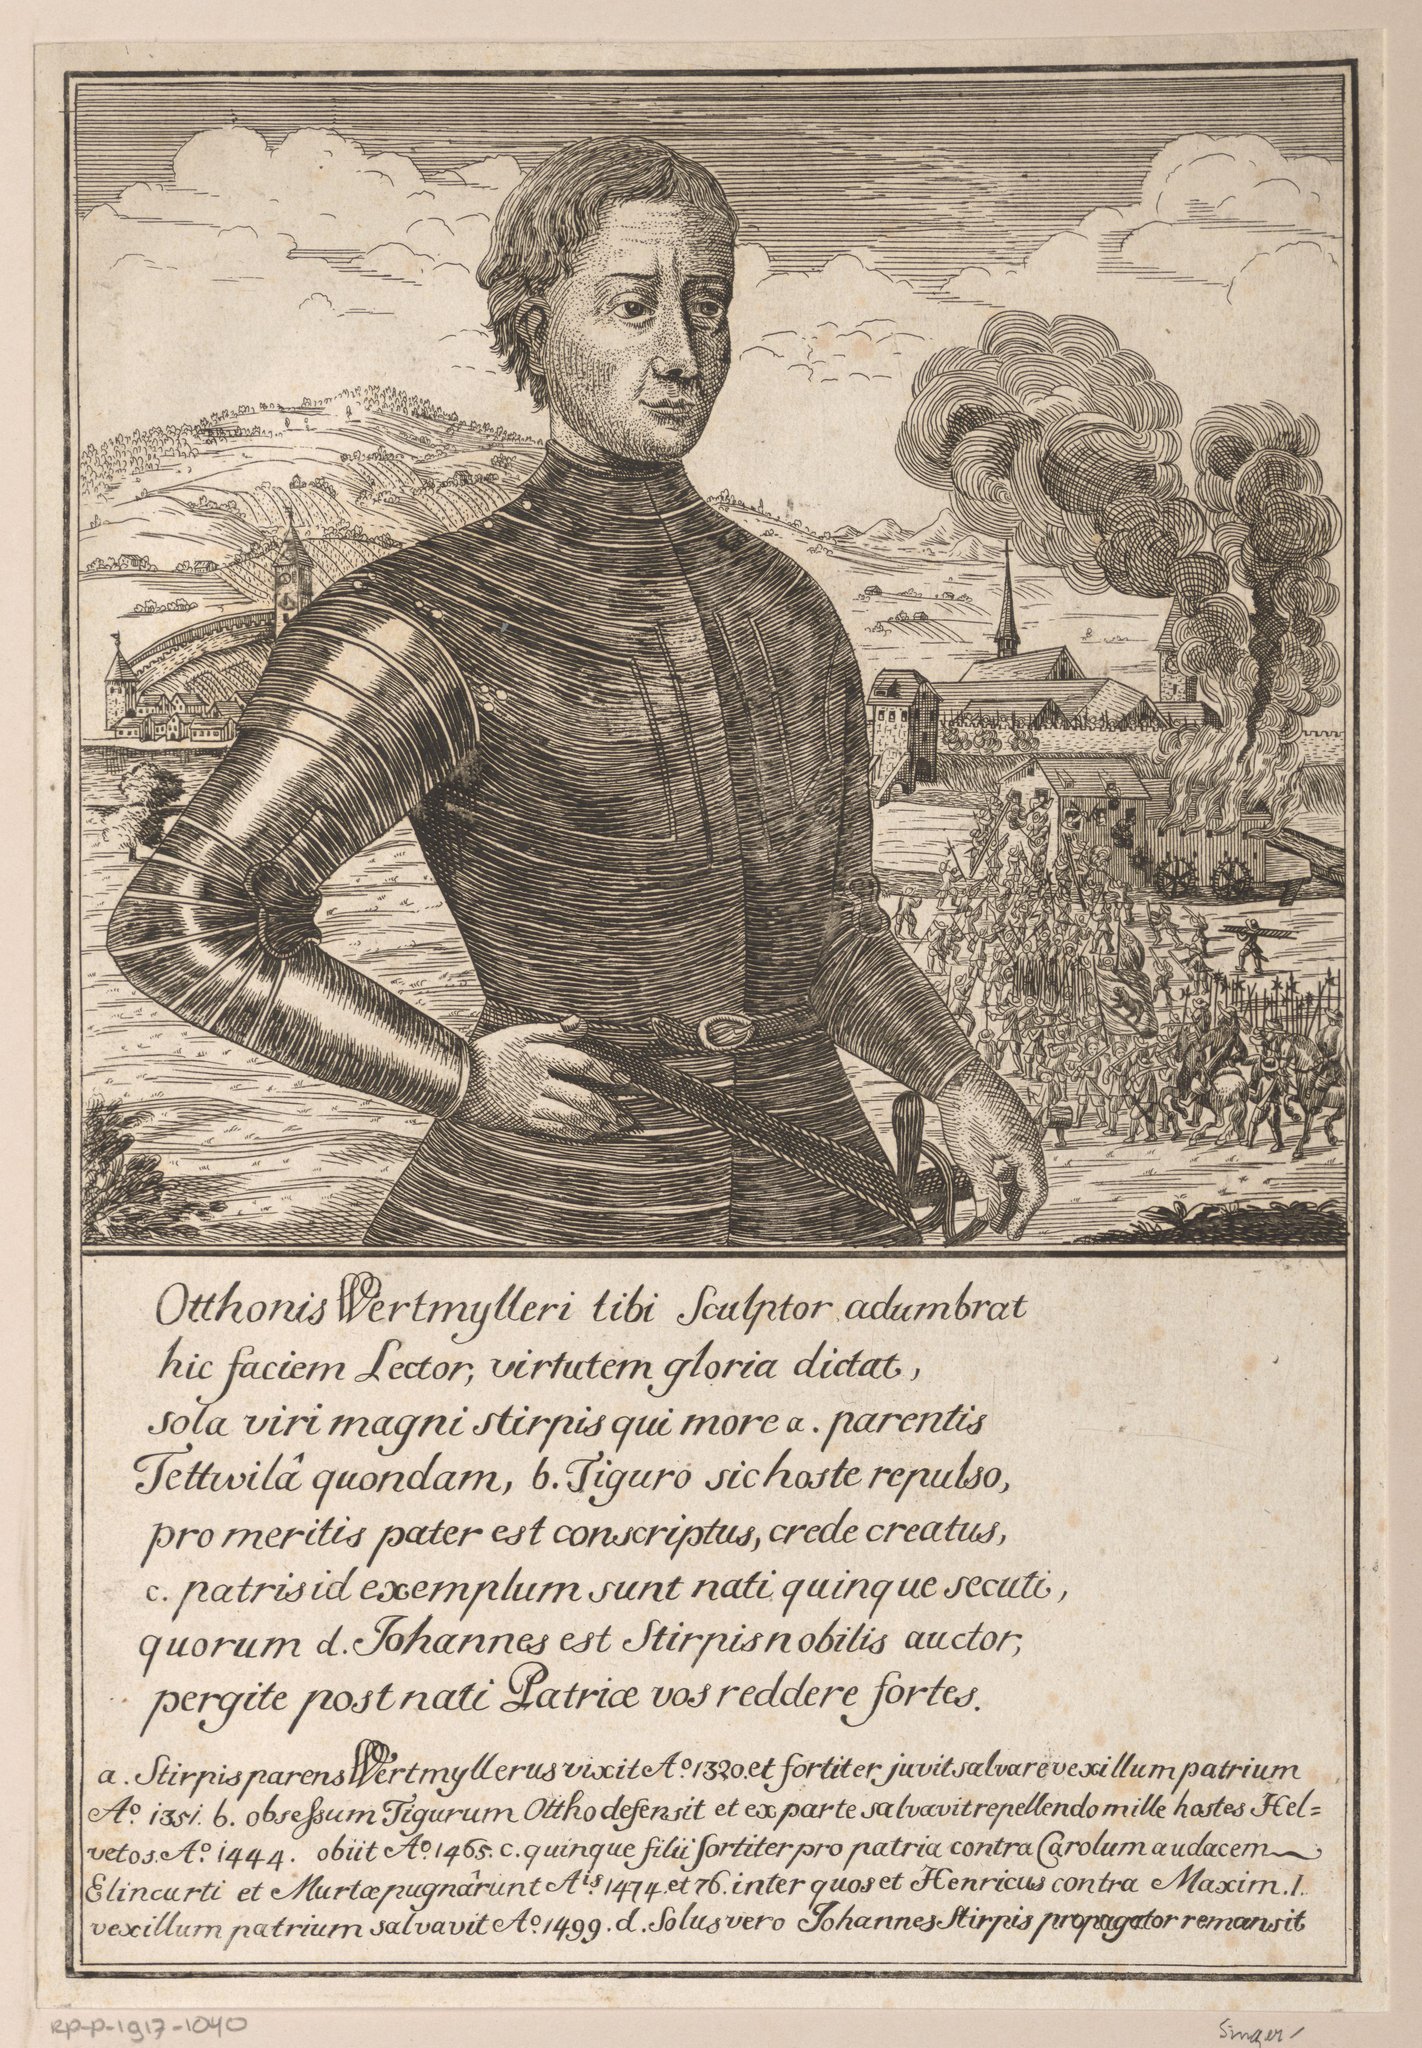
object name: print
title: Portret van Otto Werdmüller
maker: Anonymous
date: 1750-1850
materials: paper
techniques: etching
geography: switzerland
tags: politician, mayor, burgomaster, historical persons, watermill, siege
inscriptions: collector's mark: Lugt 2228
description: Met dertien regels onderschrift in het Latijn.